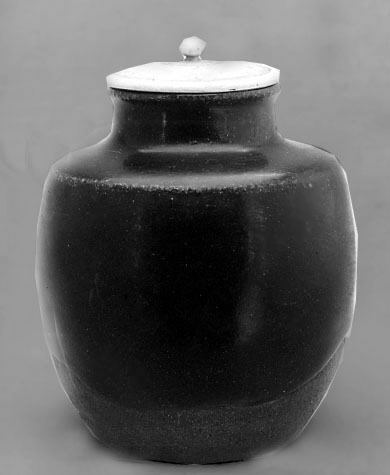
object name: tea jar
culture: japanese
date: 1701-1800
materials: clay, glaze